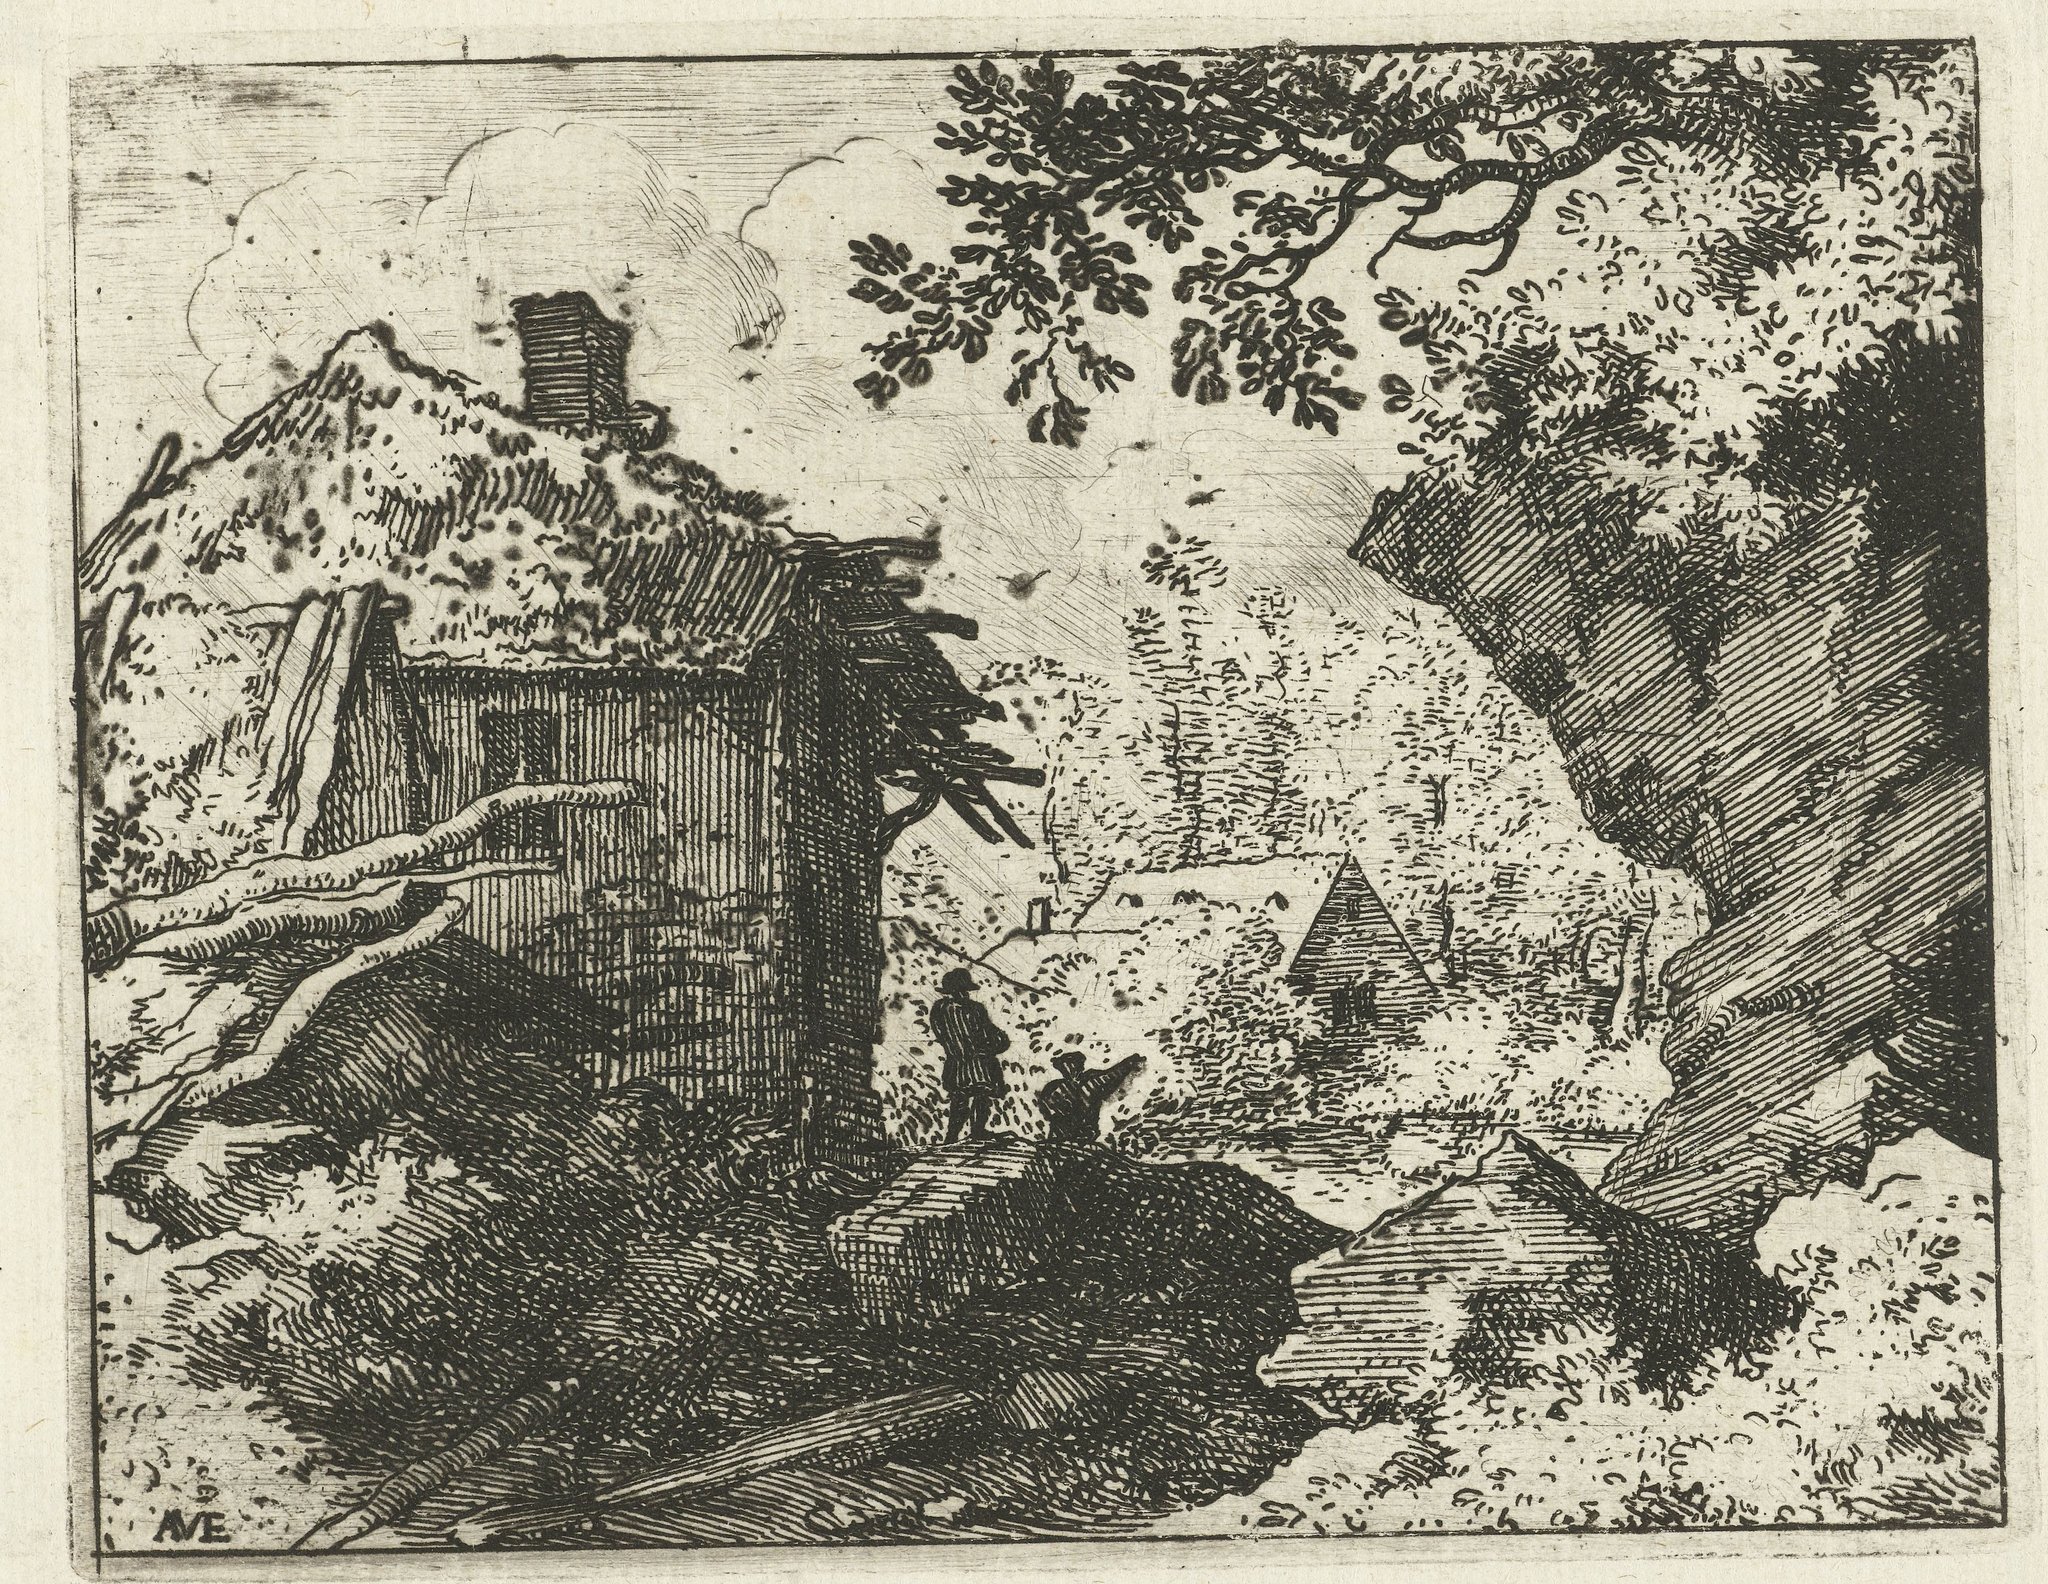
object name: print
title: Twee personen bij een vervallen huis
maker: allaert van everdingen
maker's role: draughtsman, painter, print maker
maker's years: 1621-1675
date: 1631-1675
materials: paper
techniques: etching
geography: netherlands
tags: landscape with ruins (+ city(-scape) with figures, staffage)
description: Gezicht op een huis waarvan het rieten dak deels onbedekt is. Naast het huis staan twee personen. Op de achtergrond enkele daken tussen de bomen.